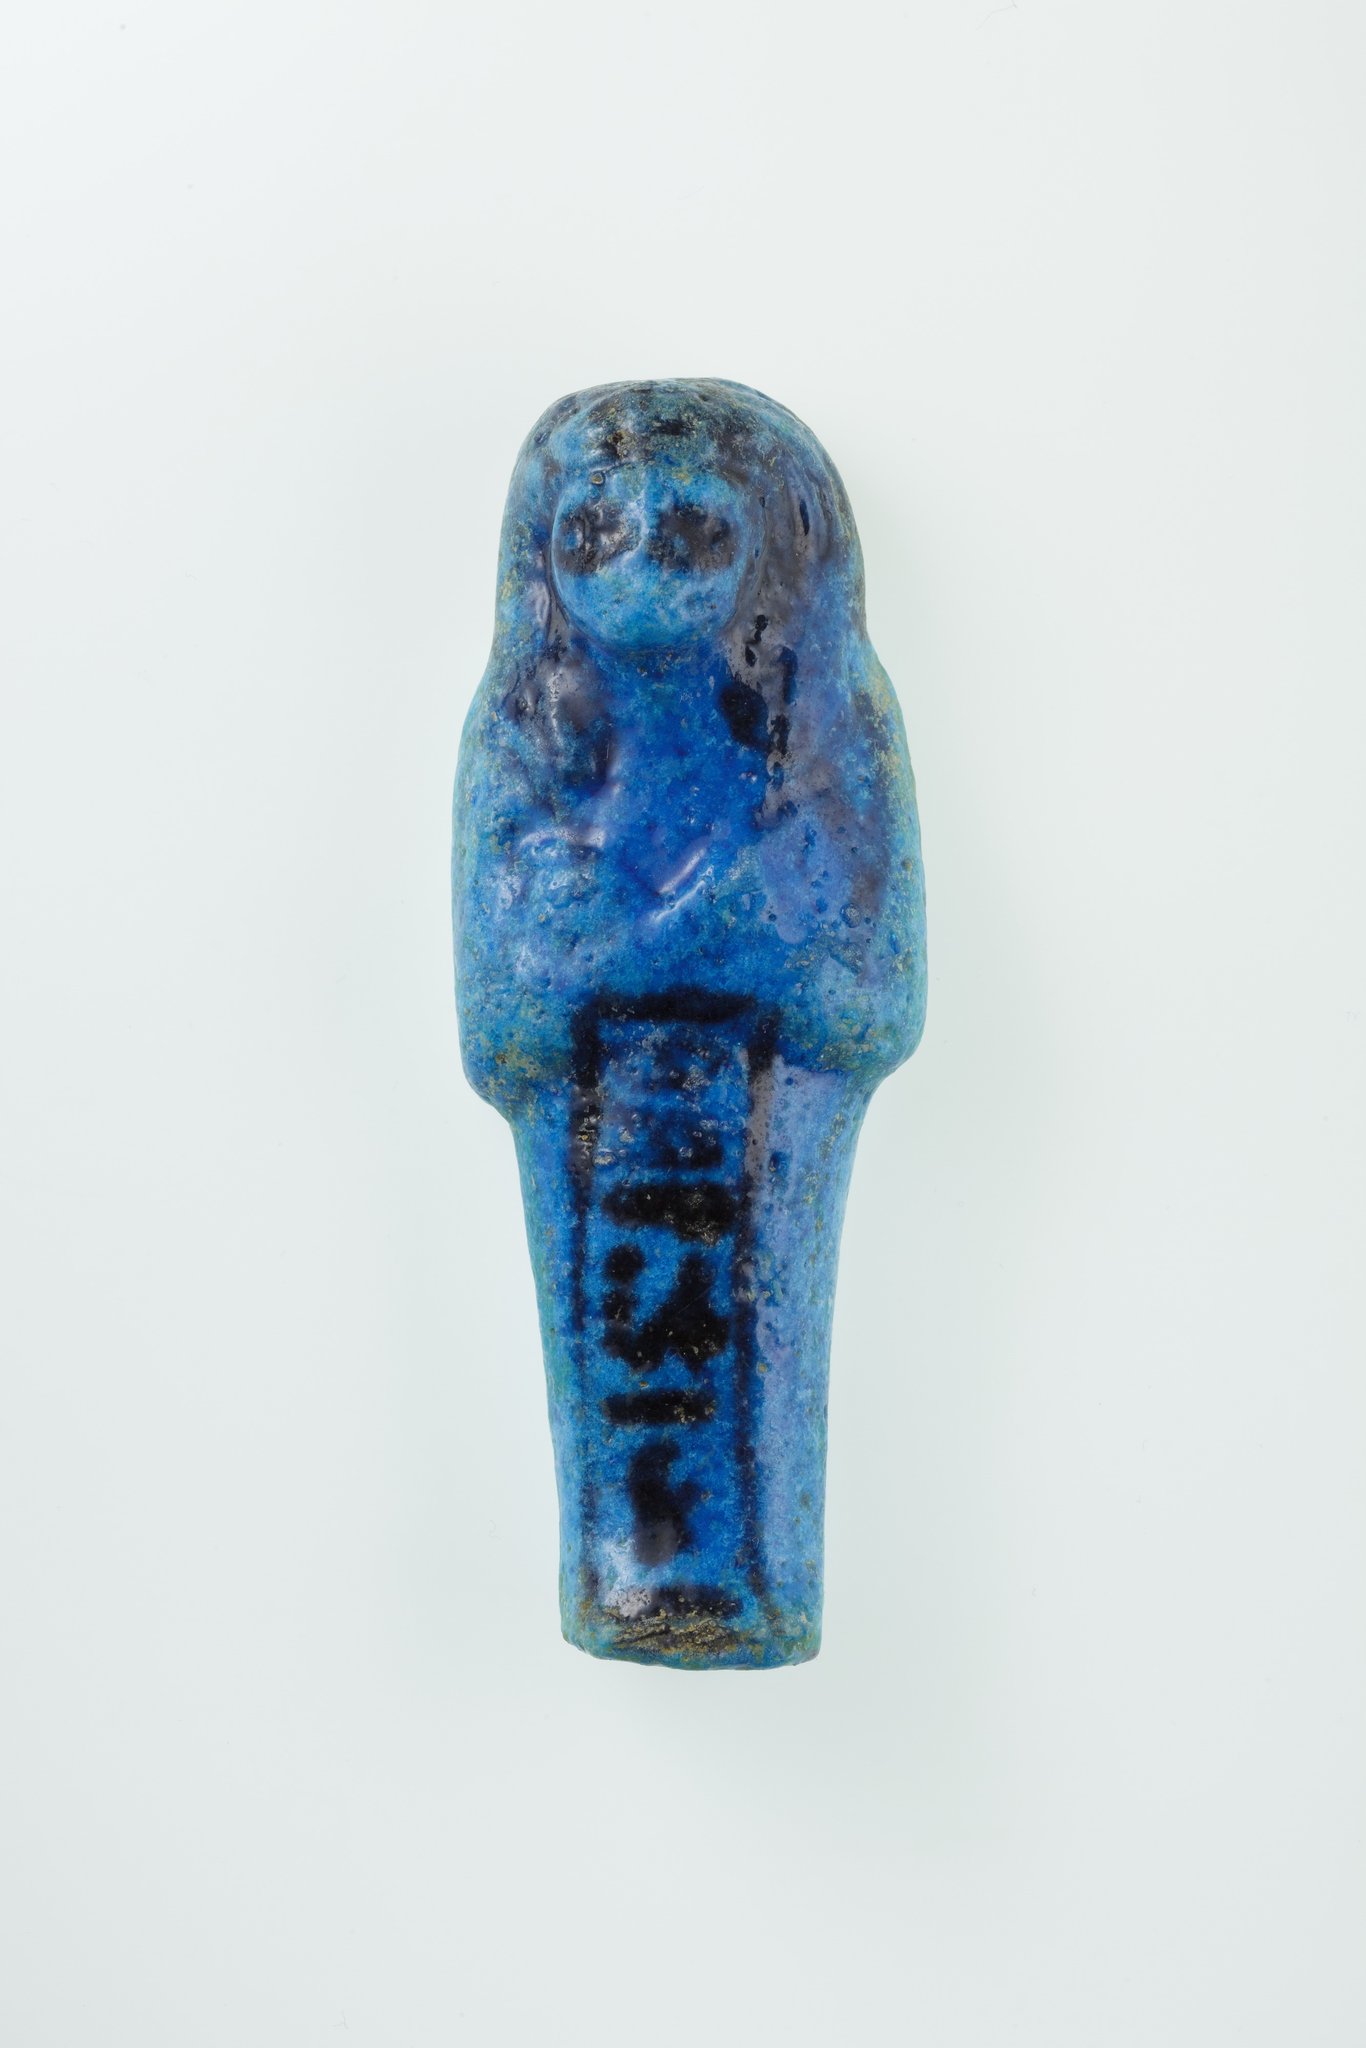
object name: shabti, worker, nauny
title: Worker Shabti of Nauny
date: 1050 BCE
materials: faience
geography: egypt